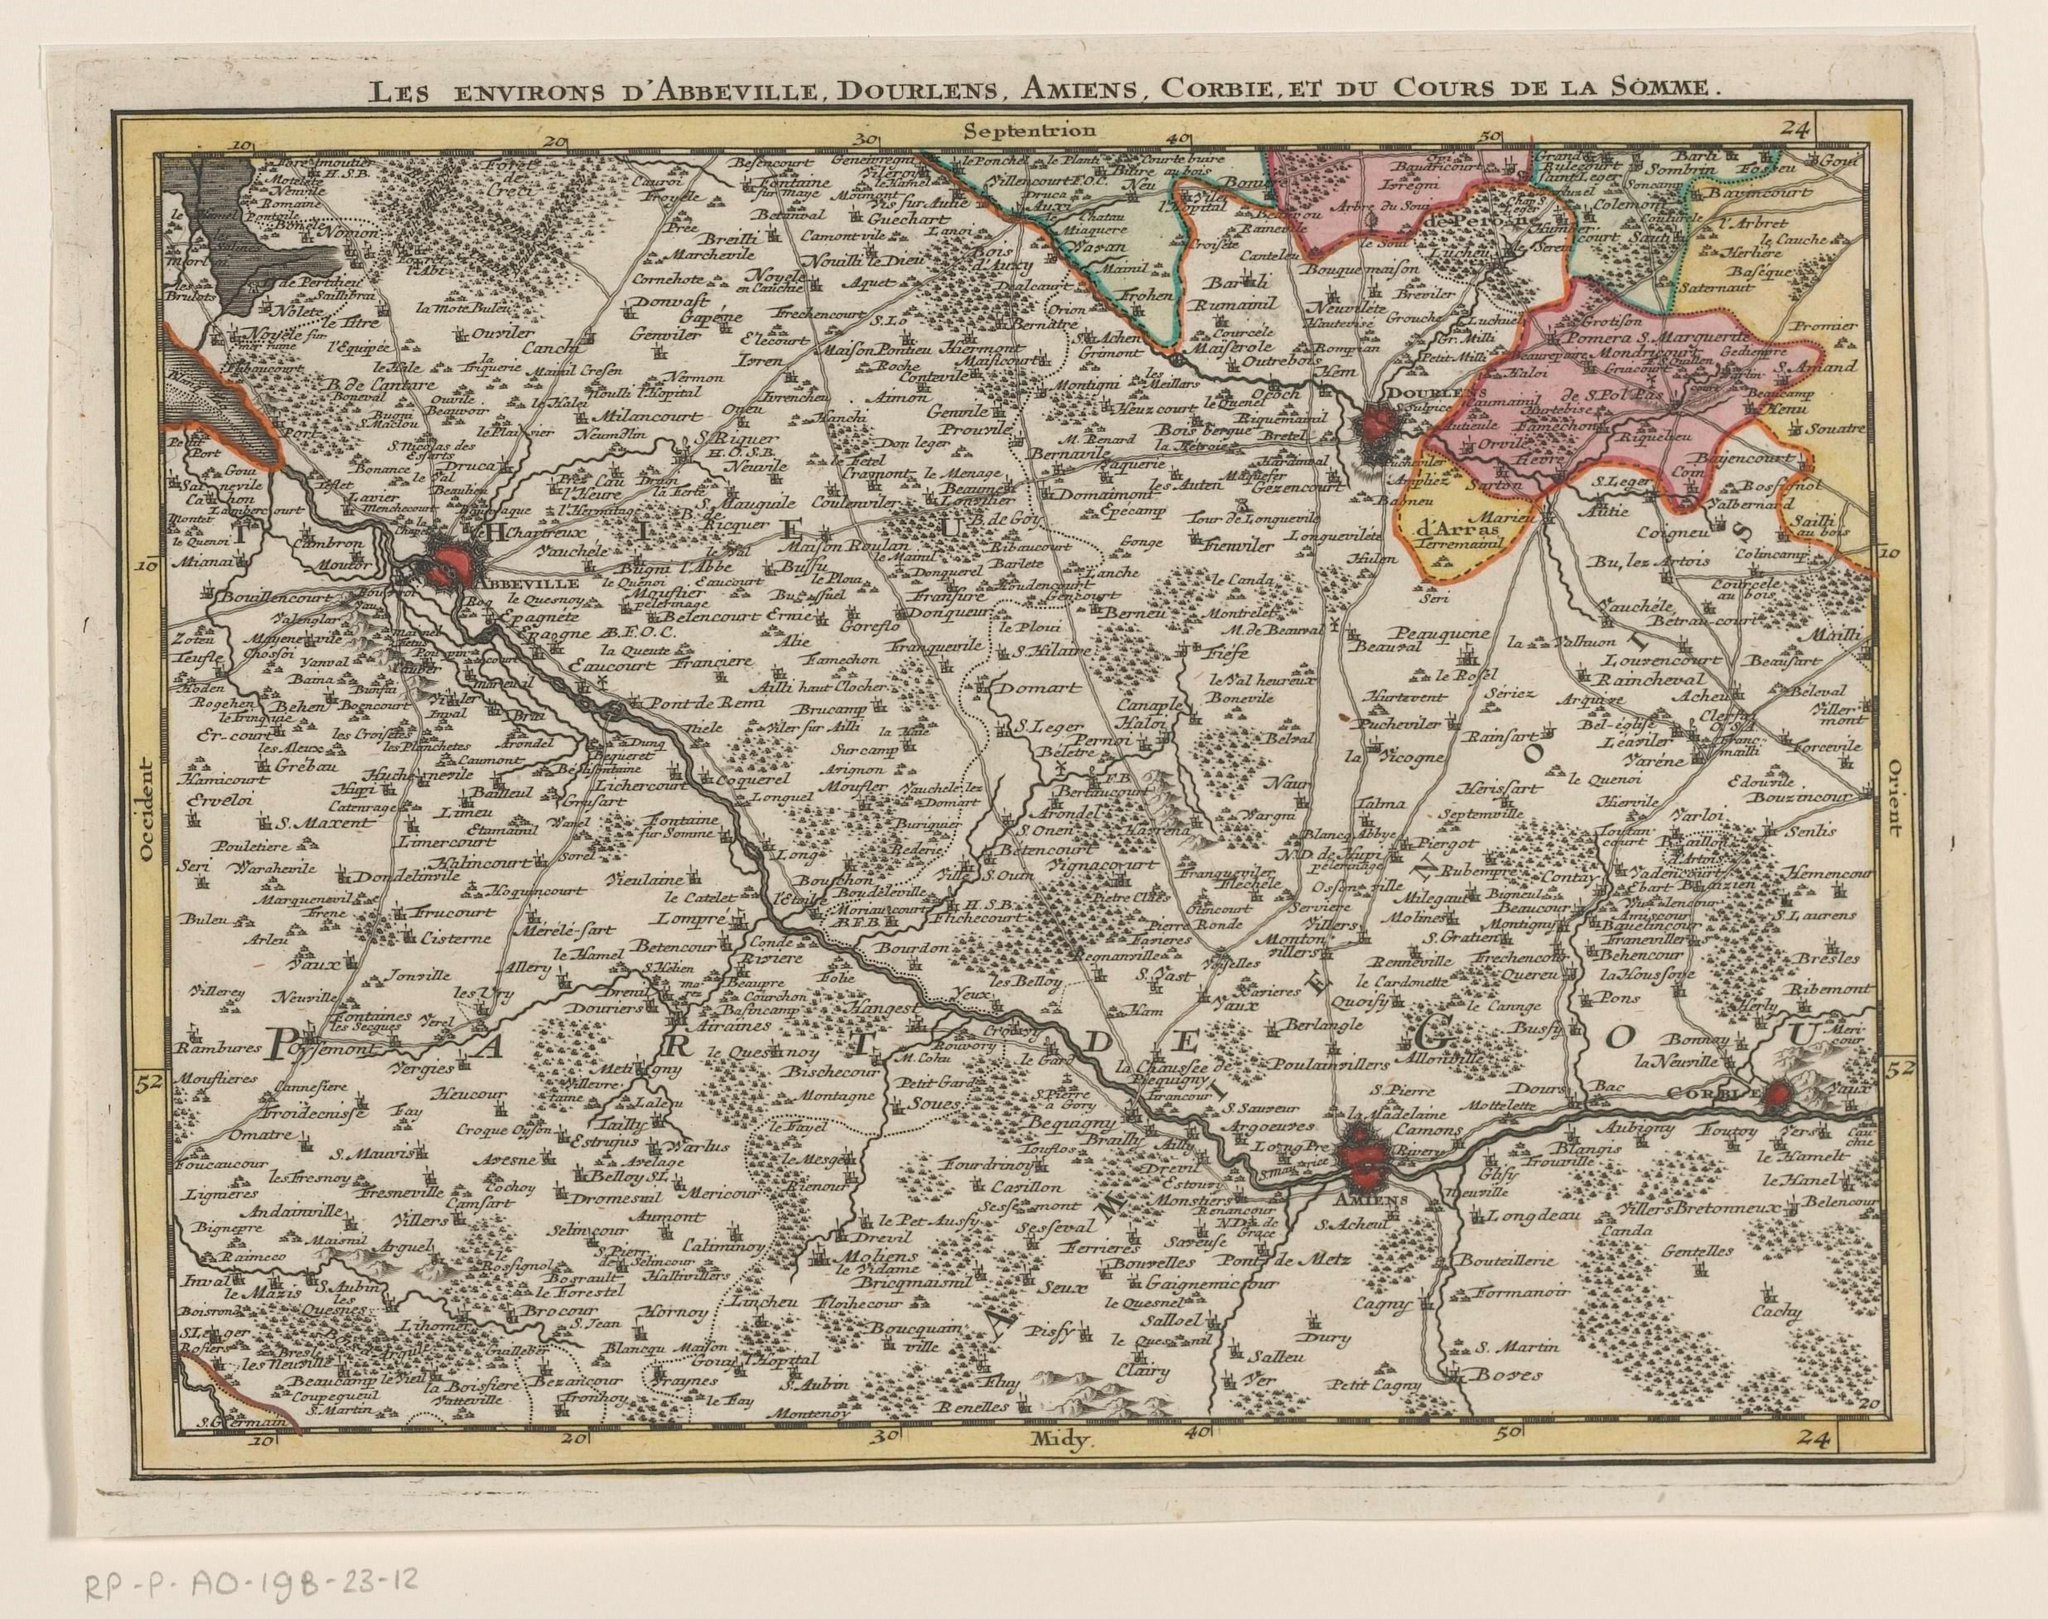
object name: map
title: Deel van een kaart van de Oostenrijkse Nederlanden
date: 1737-1757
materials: paper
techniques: engraving, hand coloring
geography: augsburg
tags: maps of separate countries or regions, southern netherlands, belgium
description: Deze kaart is onderdeel van een wandkaart van de Oostenrijkse Nederlanden, bestaande uit vier rijen van zes delen. De delen van de kaart zijn rechtsonder genummerd, beginnend bij het deel linksboven (1) tot het deel rechtsonder (24).